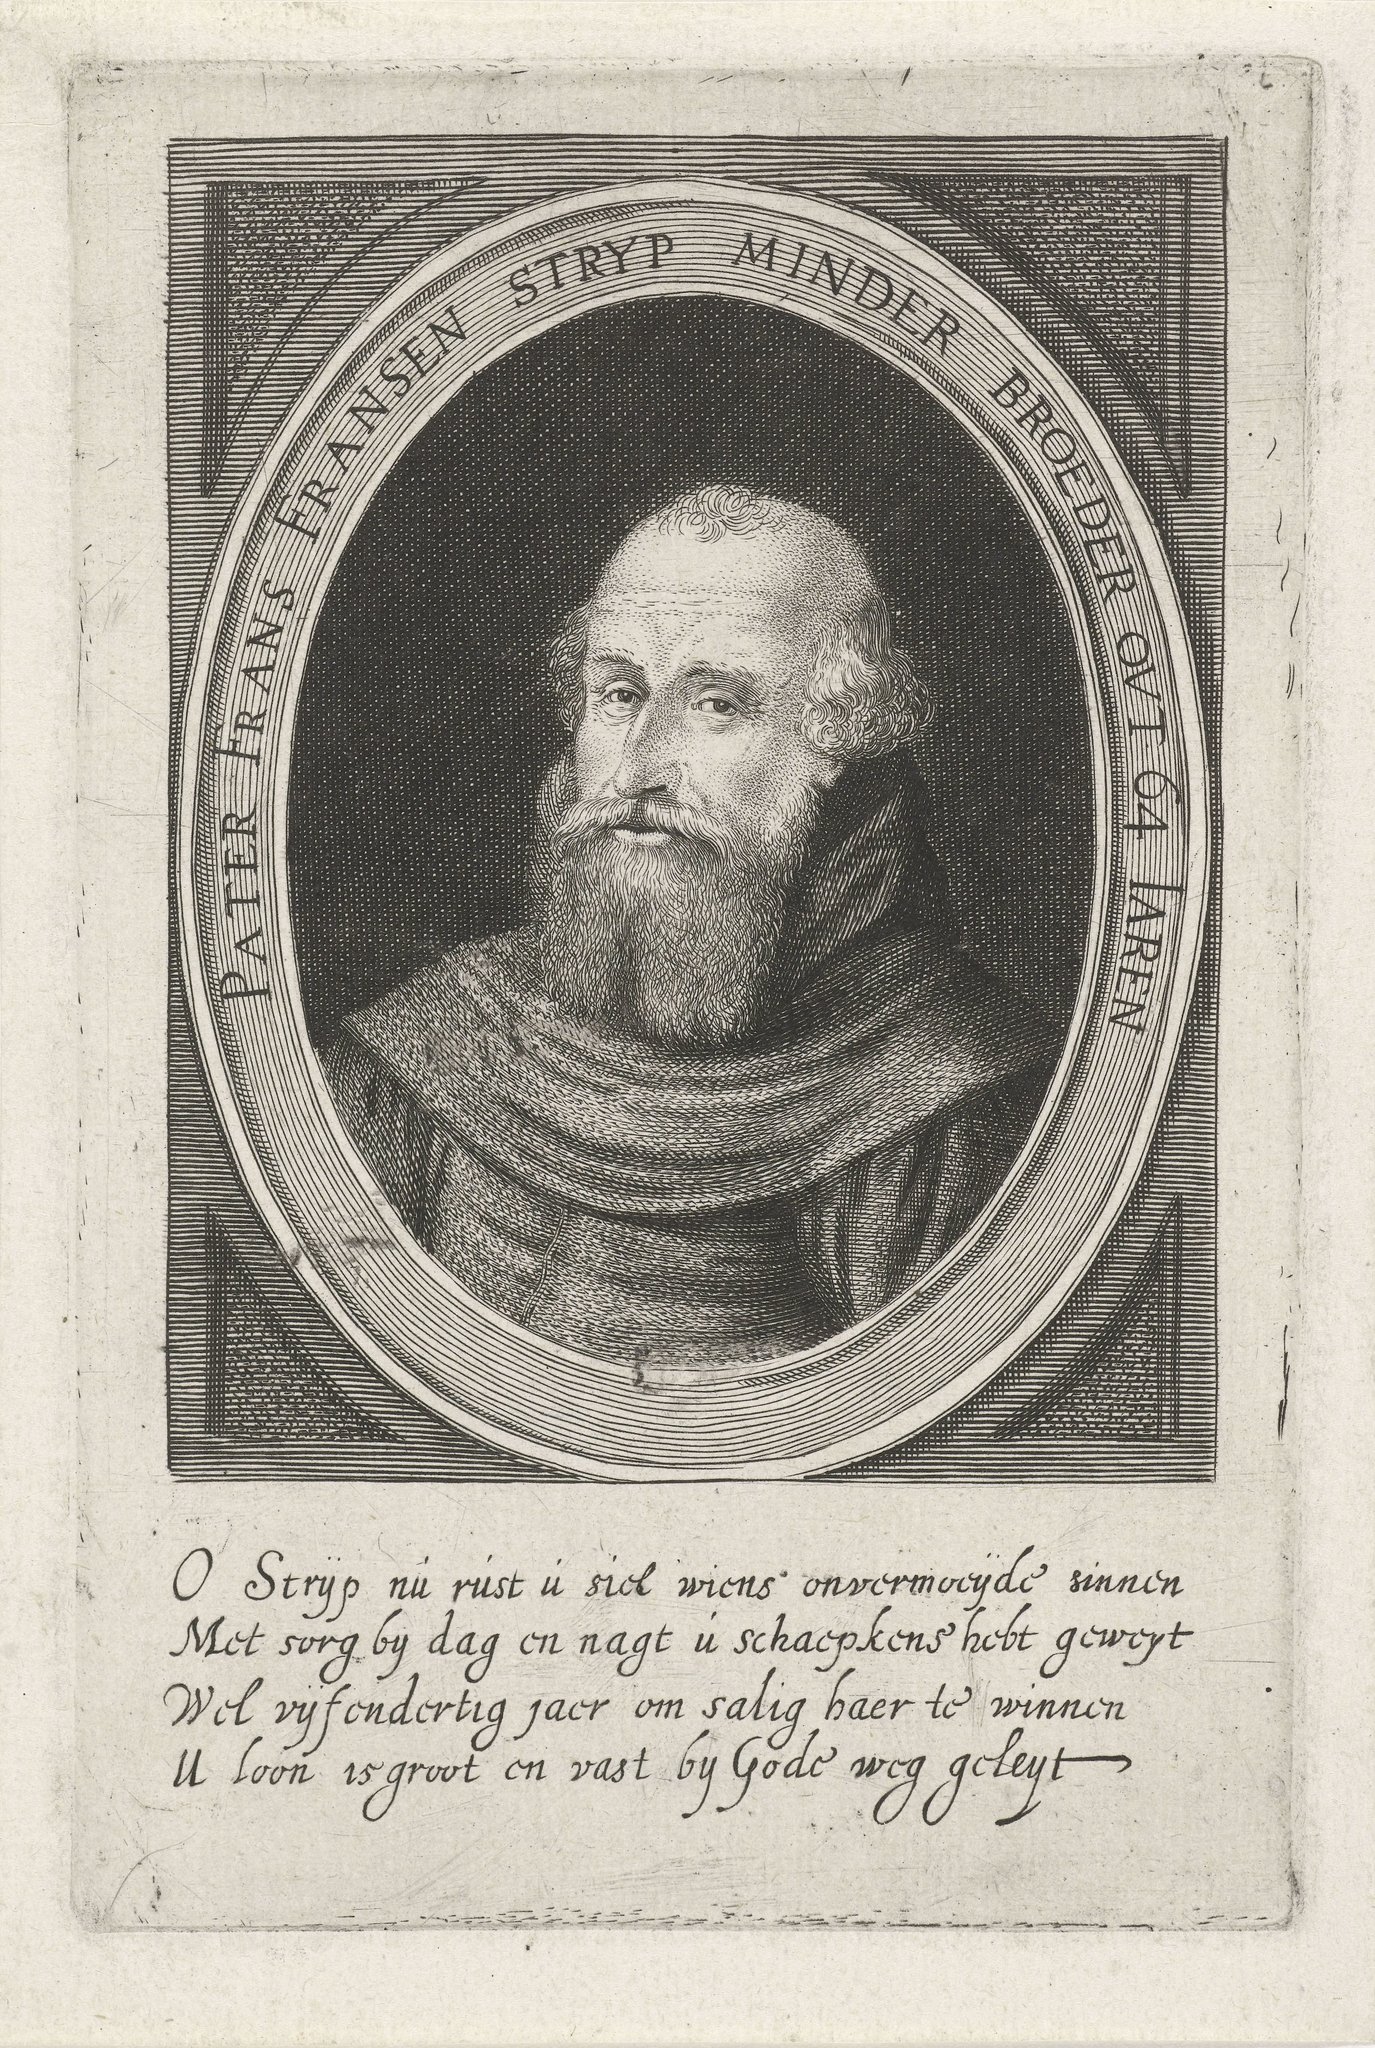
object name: print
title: Portret van Franciscus Strijp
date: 1620-1666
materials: paper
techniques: engraving, etching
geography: antwerp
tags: minderbroeder, franciscus strijp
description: Portretbuste naar rechts van minderbroeder Franciscus Strijp, in ovaal met randschrift. In de marge onder het portret een vierregelige tekst in het Nederlands.